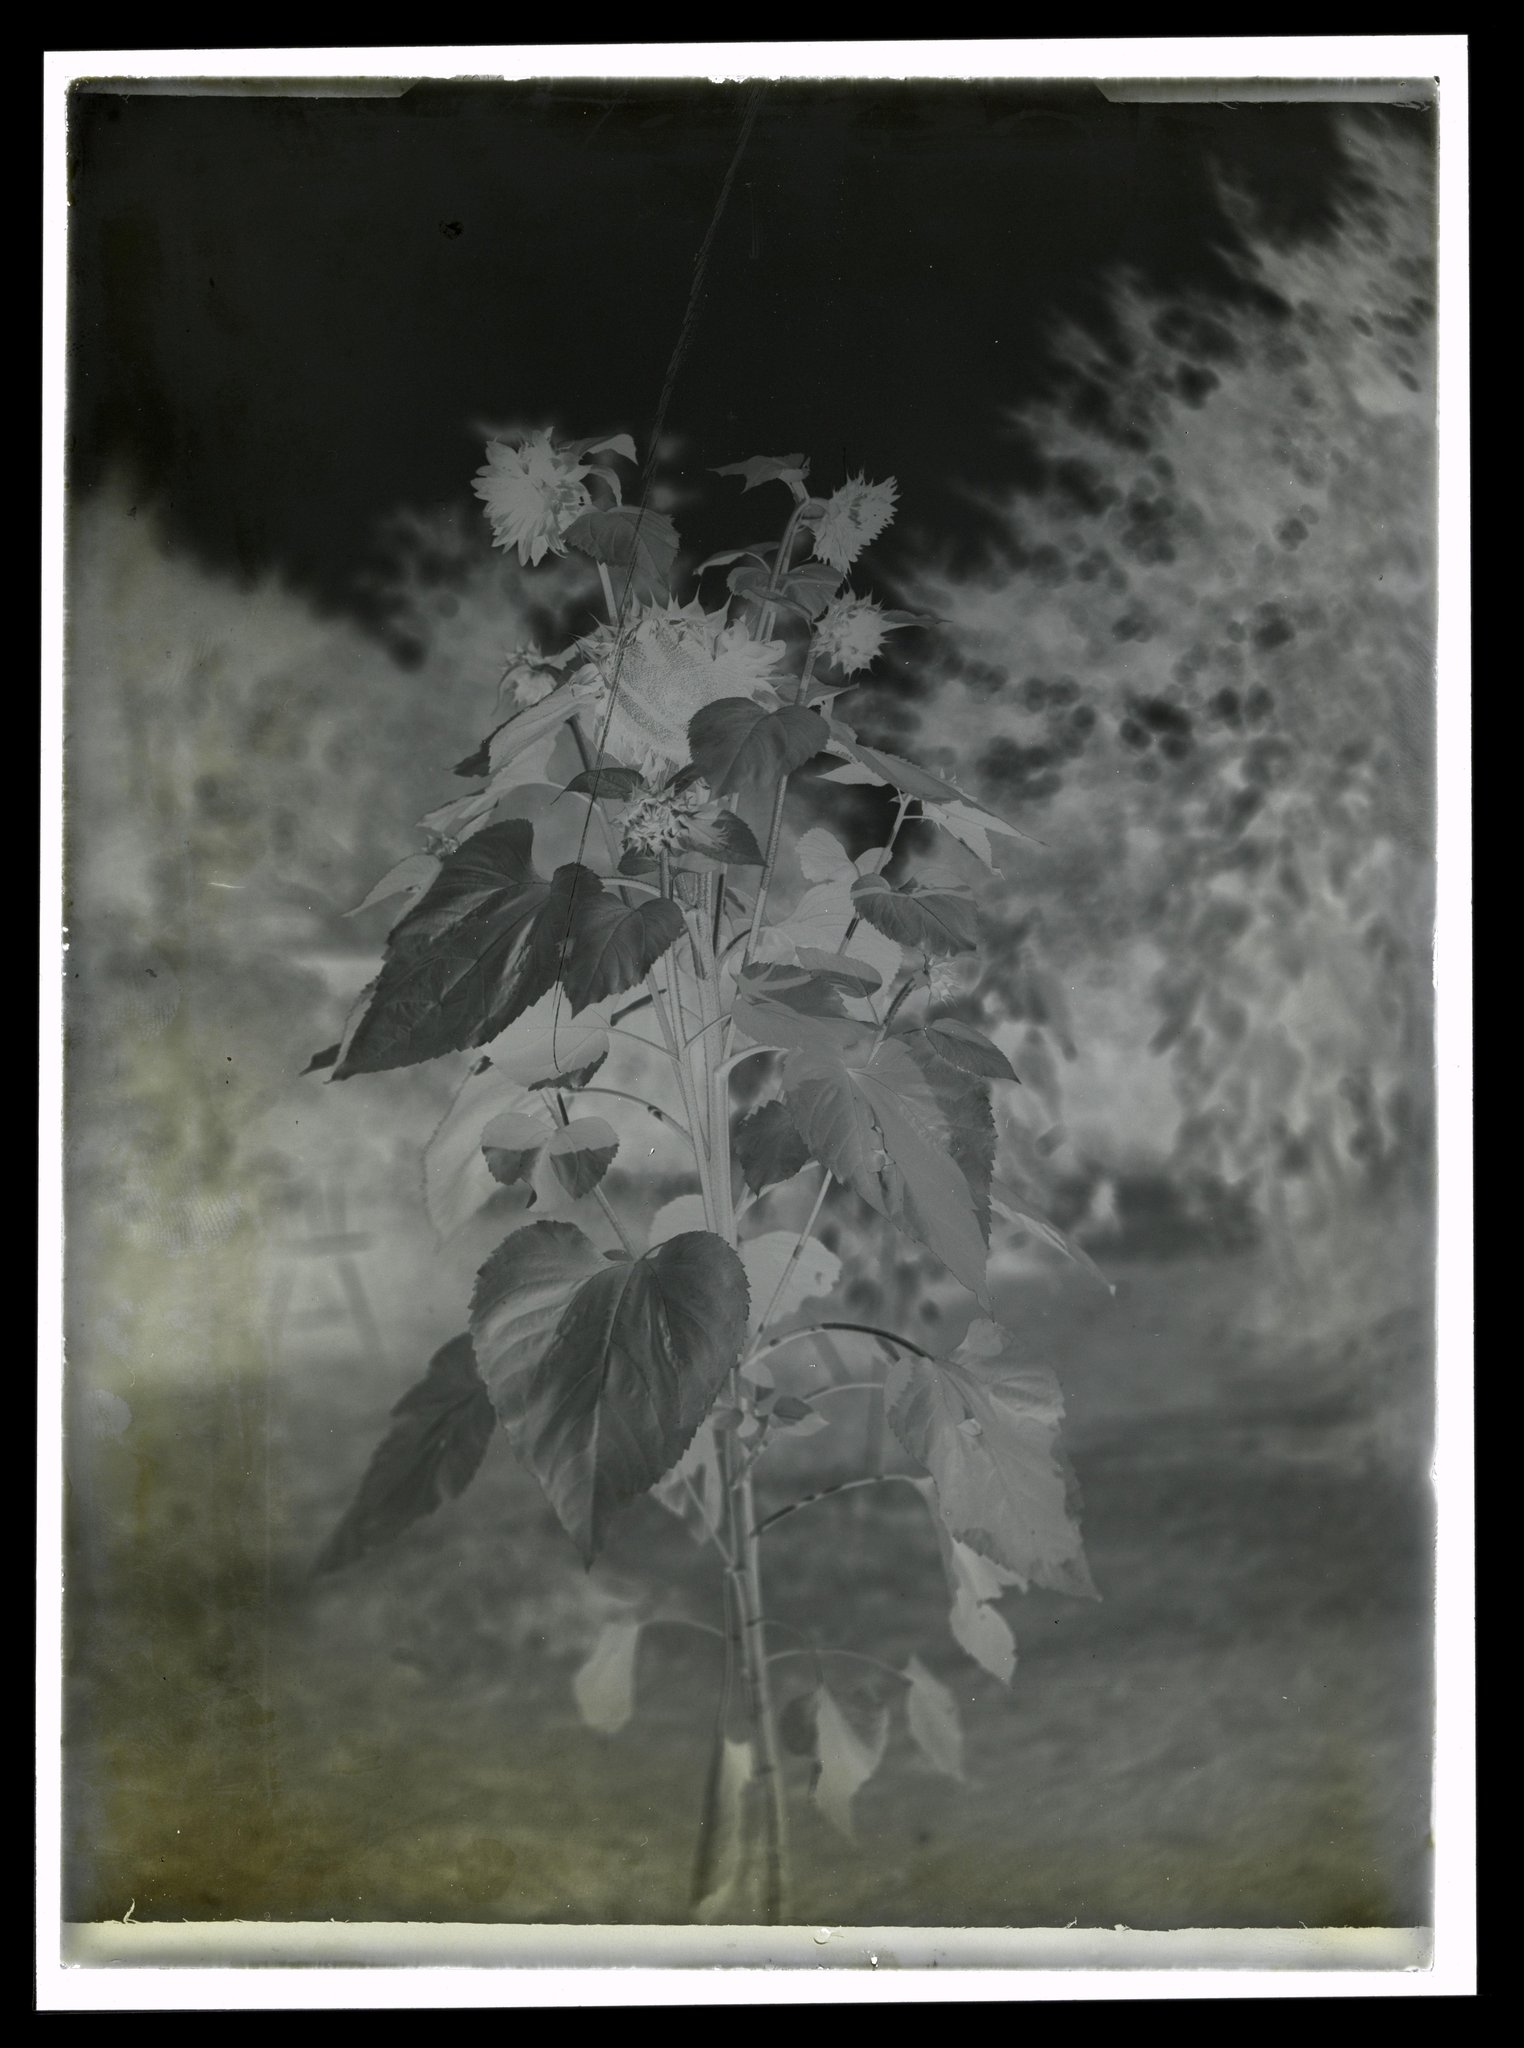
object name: glasnegatief, glasplaatnegatief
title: Zonnebloem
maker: laurens lodewijk kleijn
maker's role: draughtsman, painter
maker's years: 1826-1909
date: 1865-1900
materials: glass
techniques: collodion process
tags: flowers: sunflower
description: Onderdeel van een groep glasnegatieven uit de nalatenschap van de schilder Laurens Lodewijk Kleijn, met stillevens, portretten, zelfportretten en kunstreproducties.